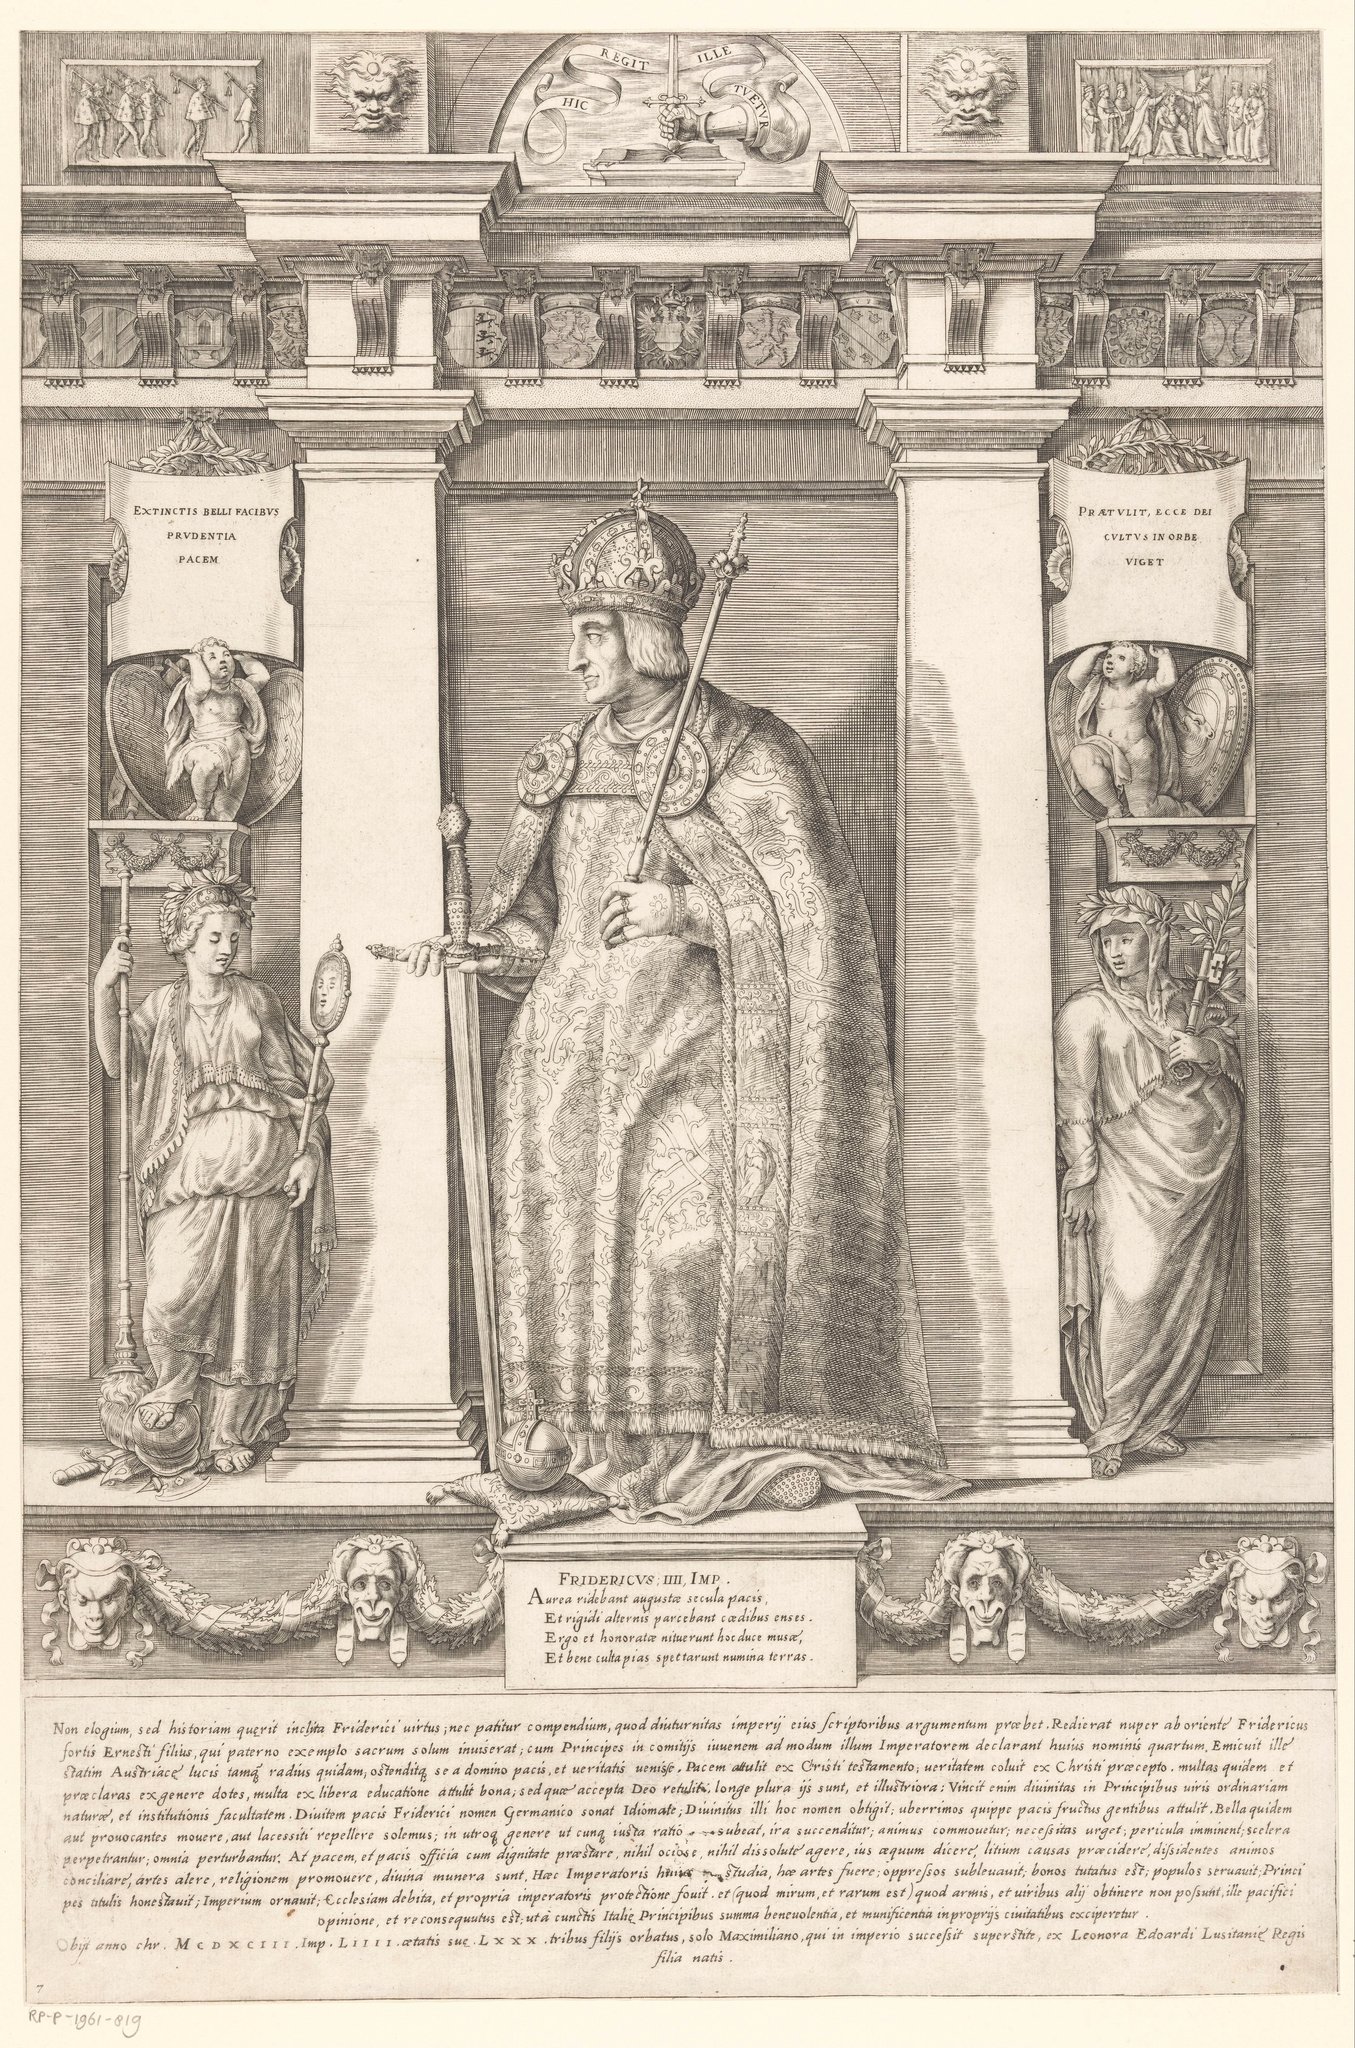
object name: print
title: Austriacae gentis imaginum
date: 1569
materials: paper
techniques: engraving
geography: italy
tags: historical persons, ruler, sovereign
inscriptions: collector's mark: Lugt 2228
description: Deze prent maakt deel uit van een reeks van 58 prenten. Het meerendeel van de prenten bevat portretten van 74 leden van het Oostenrijkse Huis, naar tekeningen door Francesco Terzio, die deels getekend zijn naar de 28 levensgrote bronzen beelden die rond de cenotaaf van Maximiliaan I in de Hofkirche te Innsbruck staan.